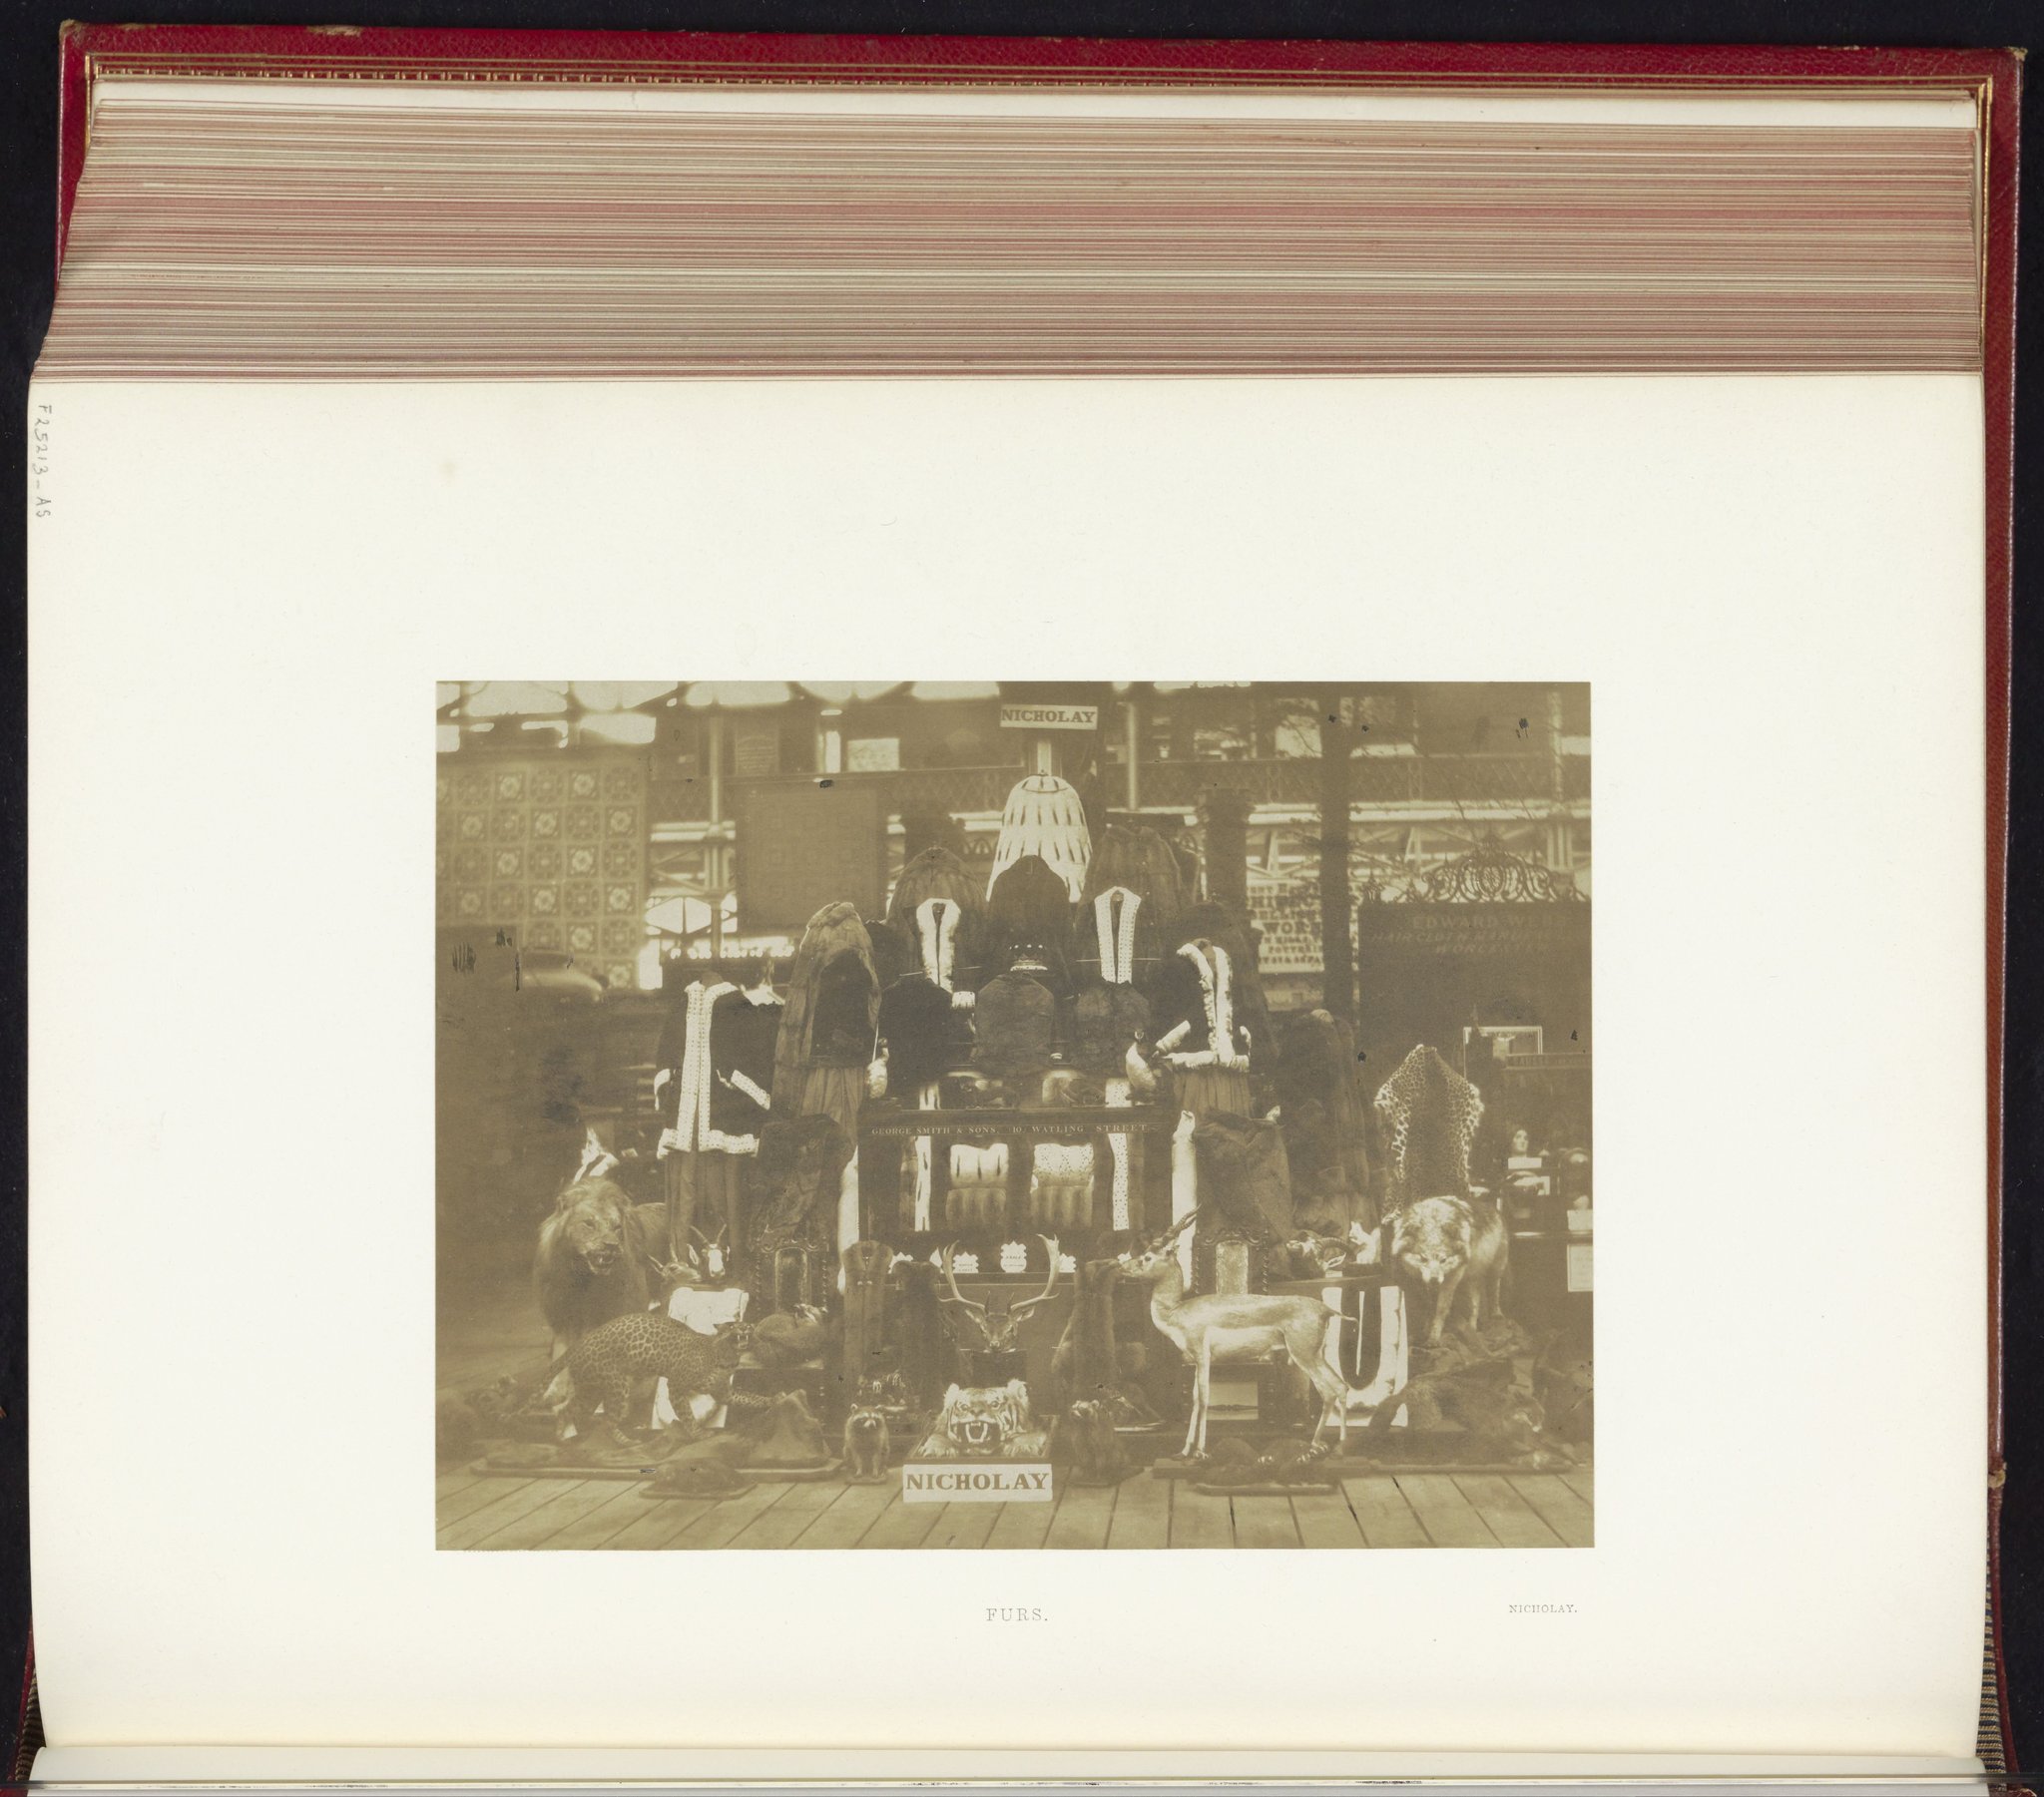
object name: photograph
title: Bontjassen en opgezette dieren van Nicholay op de Great Exhibition of the Works of Industry of All Nations van 1851 in Londen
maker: hugh owen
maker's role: fotograaf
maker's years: 1808-1897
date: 1851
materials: photographic support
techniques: salted paper print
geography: london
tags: furrier, london